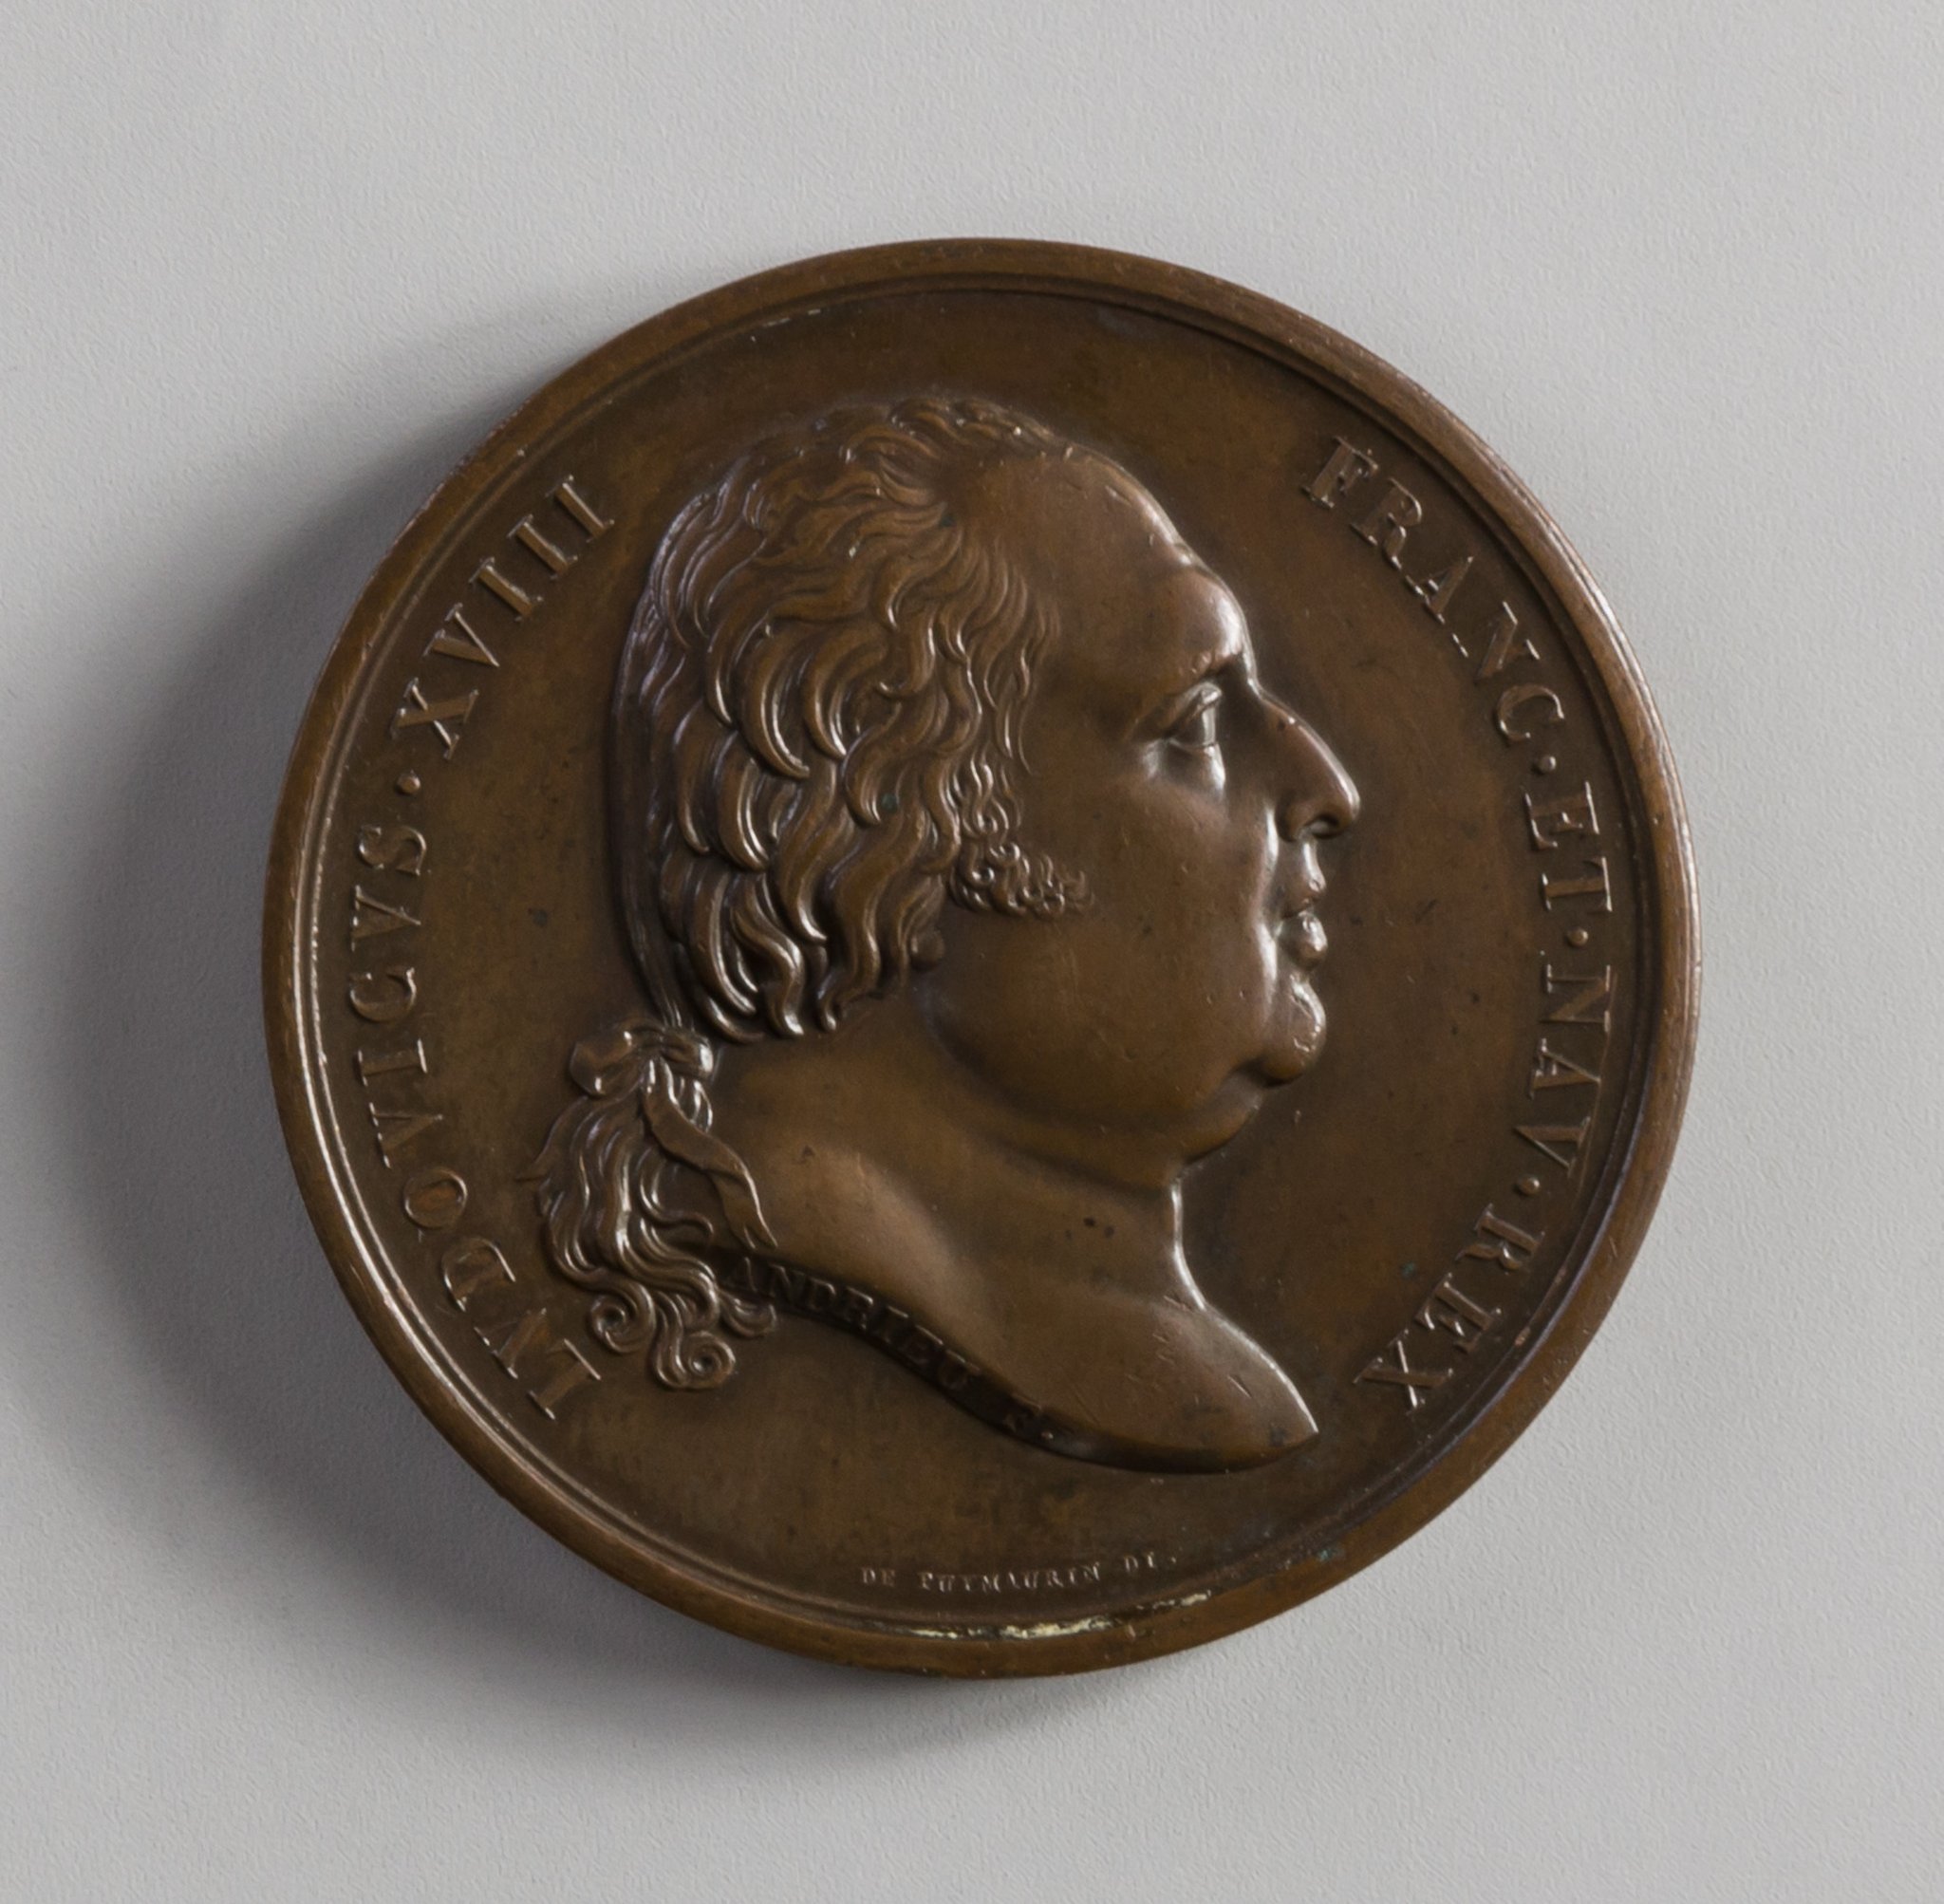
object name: medal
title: Medal Commemorating the Treaty of Commerce between France and the United States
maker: bertrand andrieu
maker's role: maker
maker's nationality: french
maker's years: 1761-1822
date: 1822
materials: bronze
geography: france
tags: men,profiles